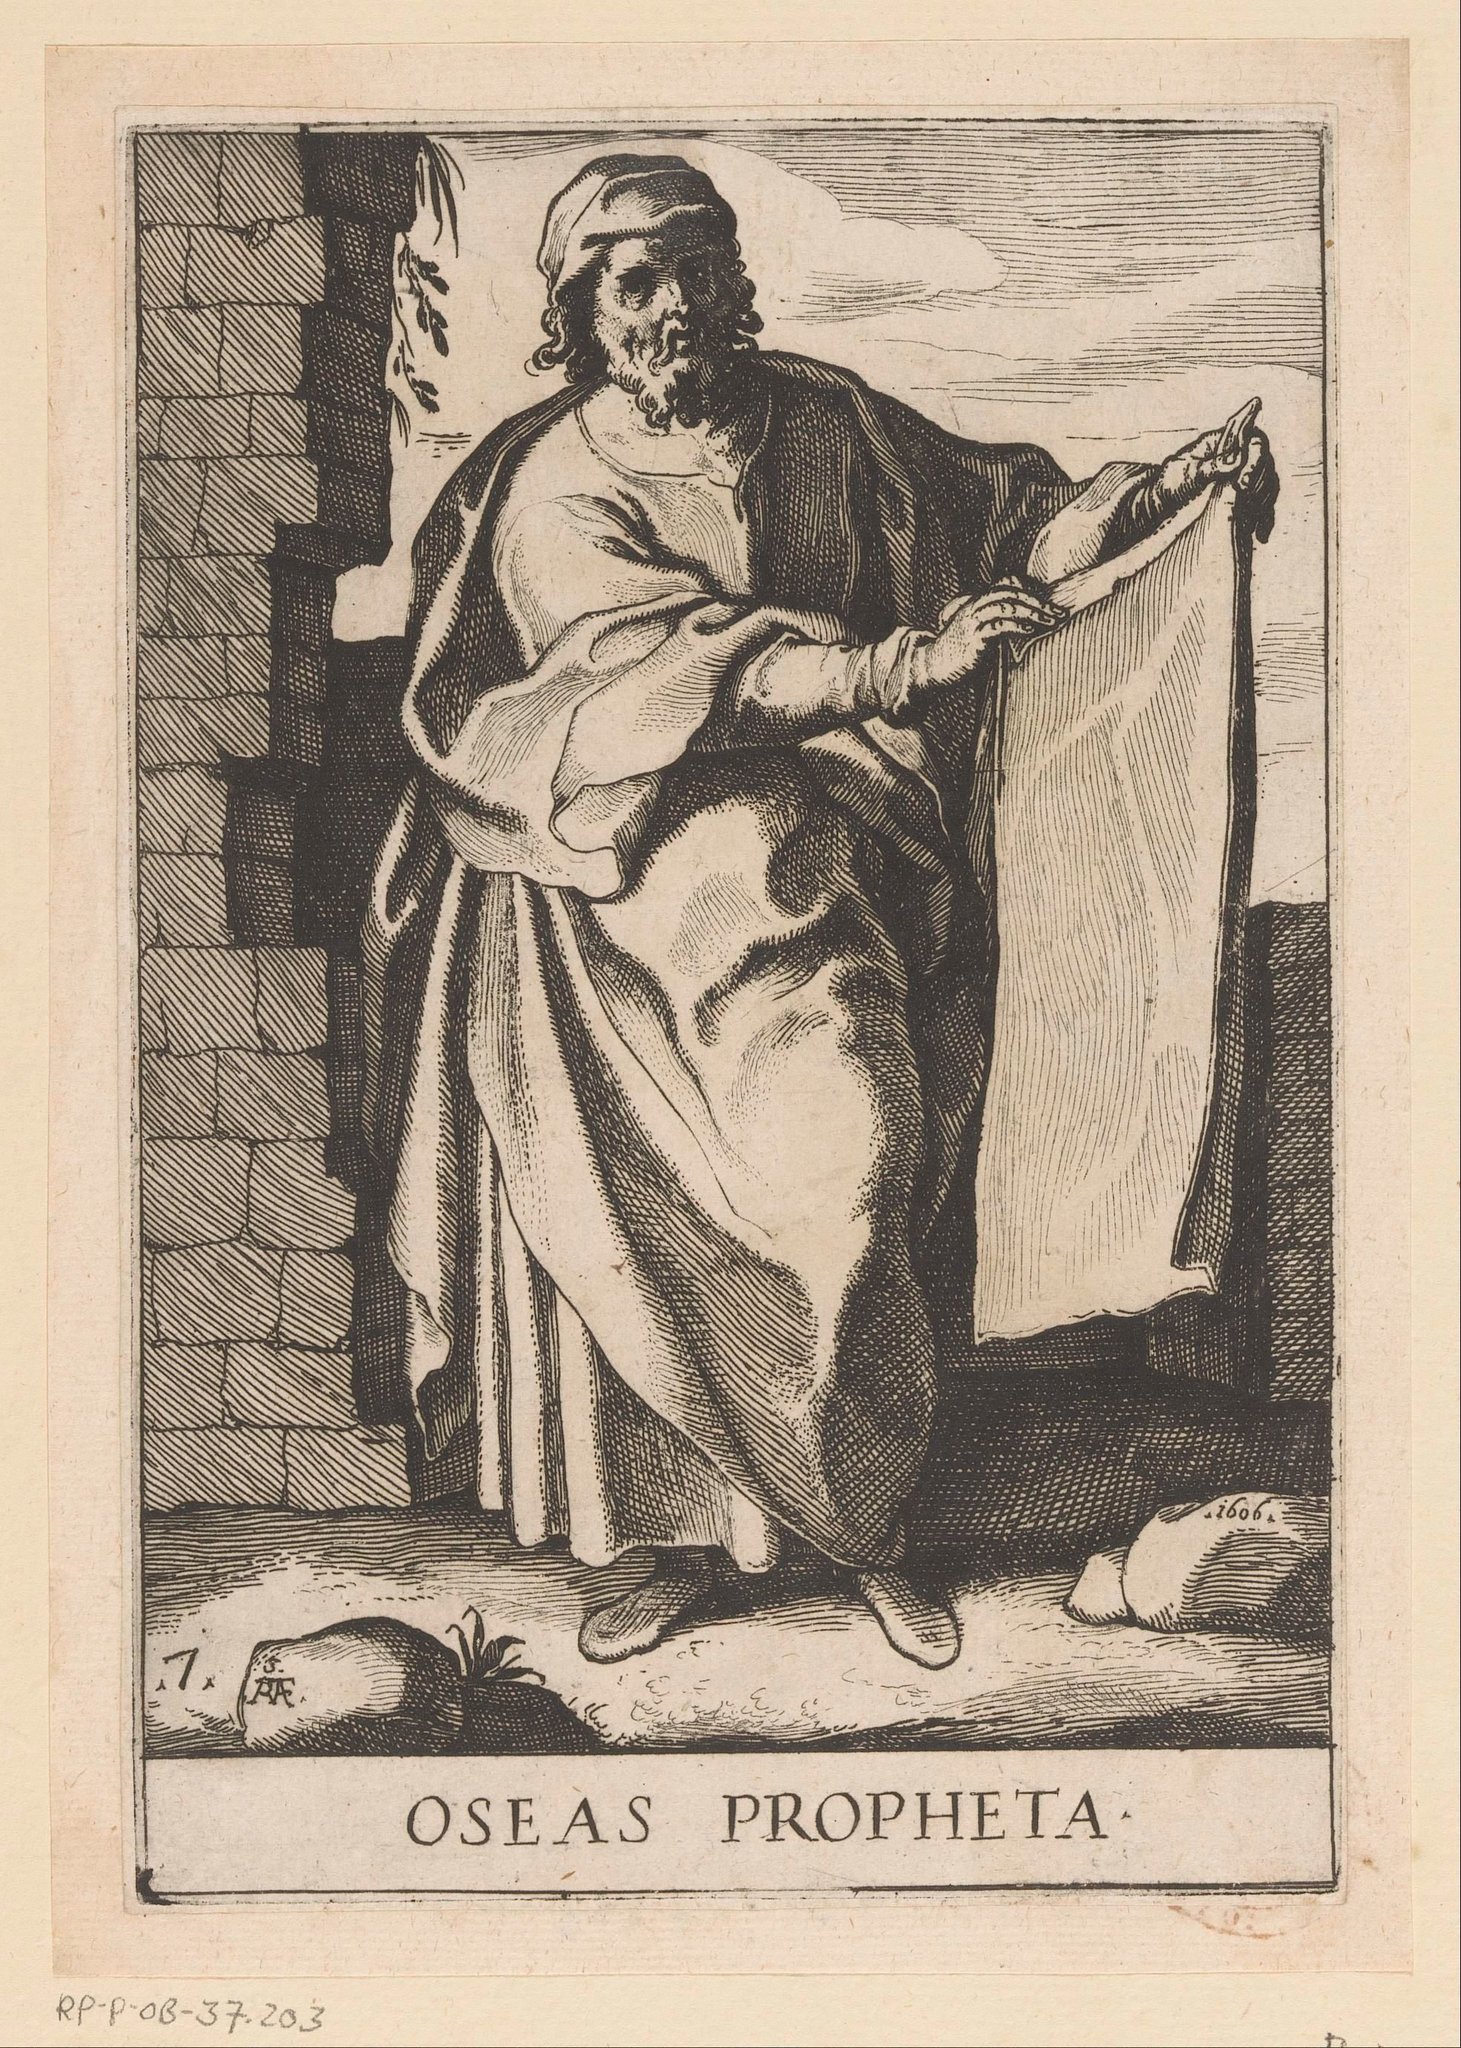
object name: print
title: Oseas propheta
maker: raffaello schiaminossi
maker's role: painter, print maker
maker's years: 1572-1622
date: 1606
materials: paper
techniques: etching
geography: italy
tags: prophets, sibyls, evangelists, doctors of the church; persons ~ the bible (not in biblical context)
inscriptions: collector's mark: Lugt 240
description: Deze prent maakt deel uit van een serie, bestaande uit een titelprent en twaalf prenten met voorstellingen van profeten. Van de titelpagina zijn verschillende staten bekend, onder meer een staat vóór de letter met het jaartal 1606, en een staat na de letter met het jaartal 1609. Om deze reden worden de prenten uit deze serie hier 1606-1609 gedateerd, behalve in het geval van prenten die individueel gedateerd zijn.